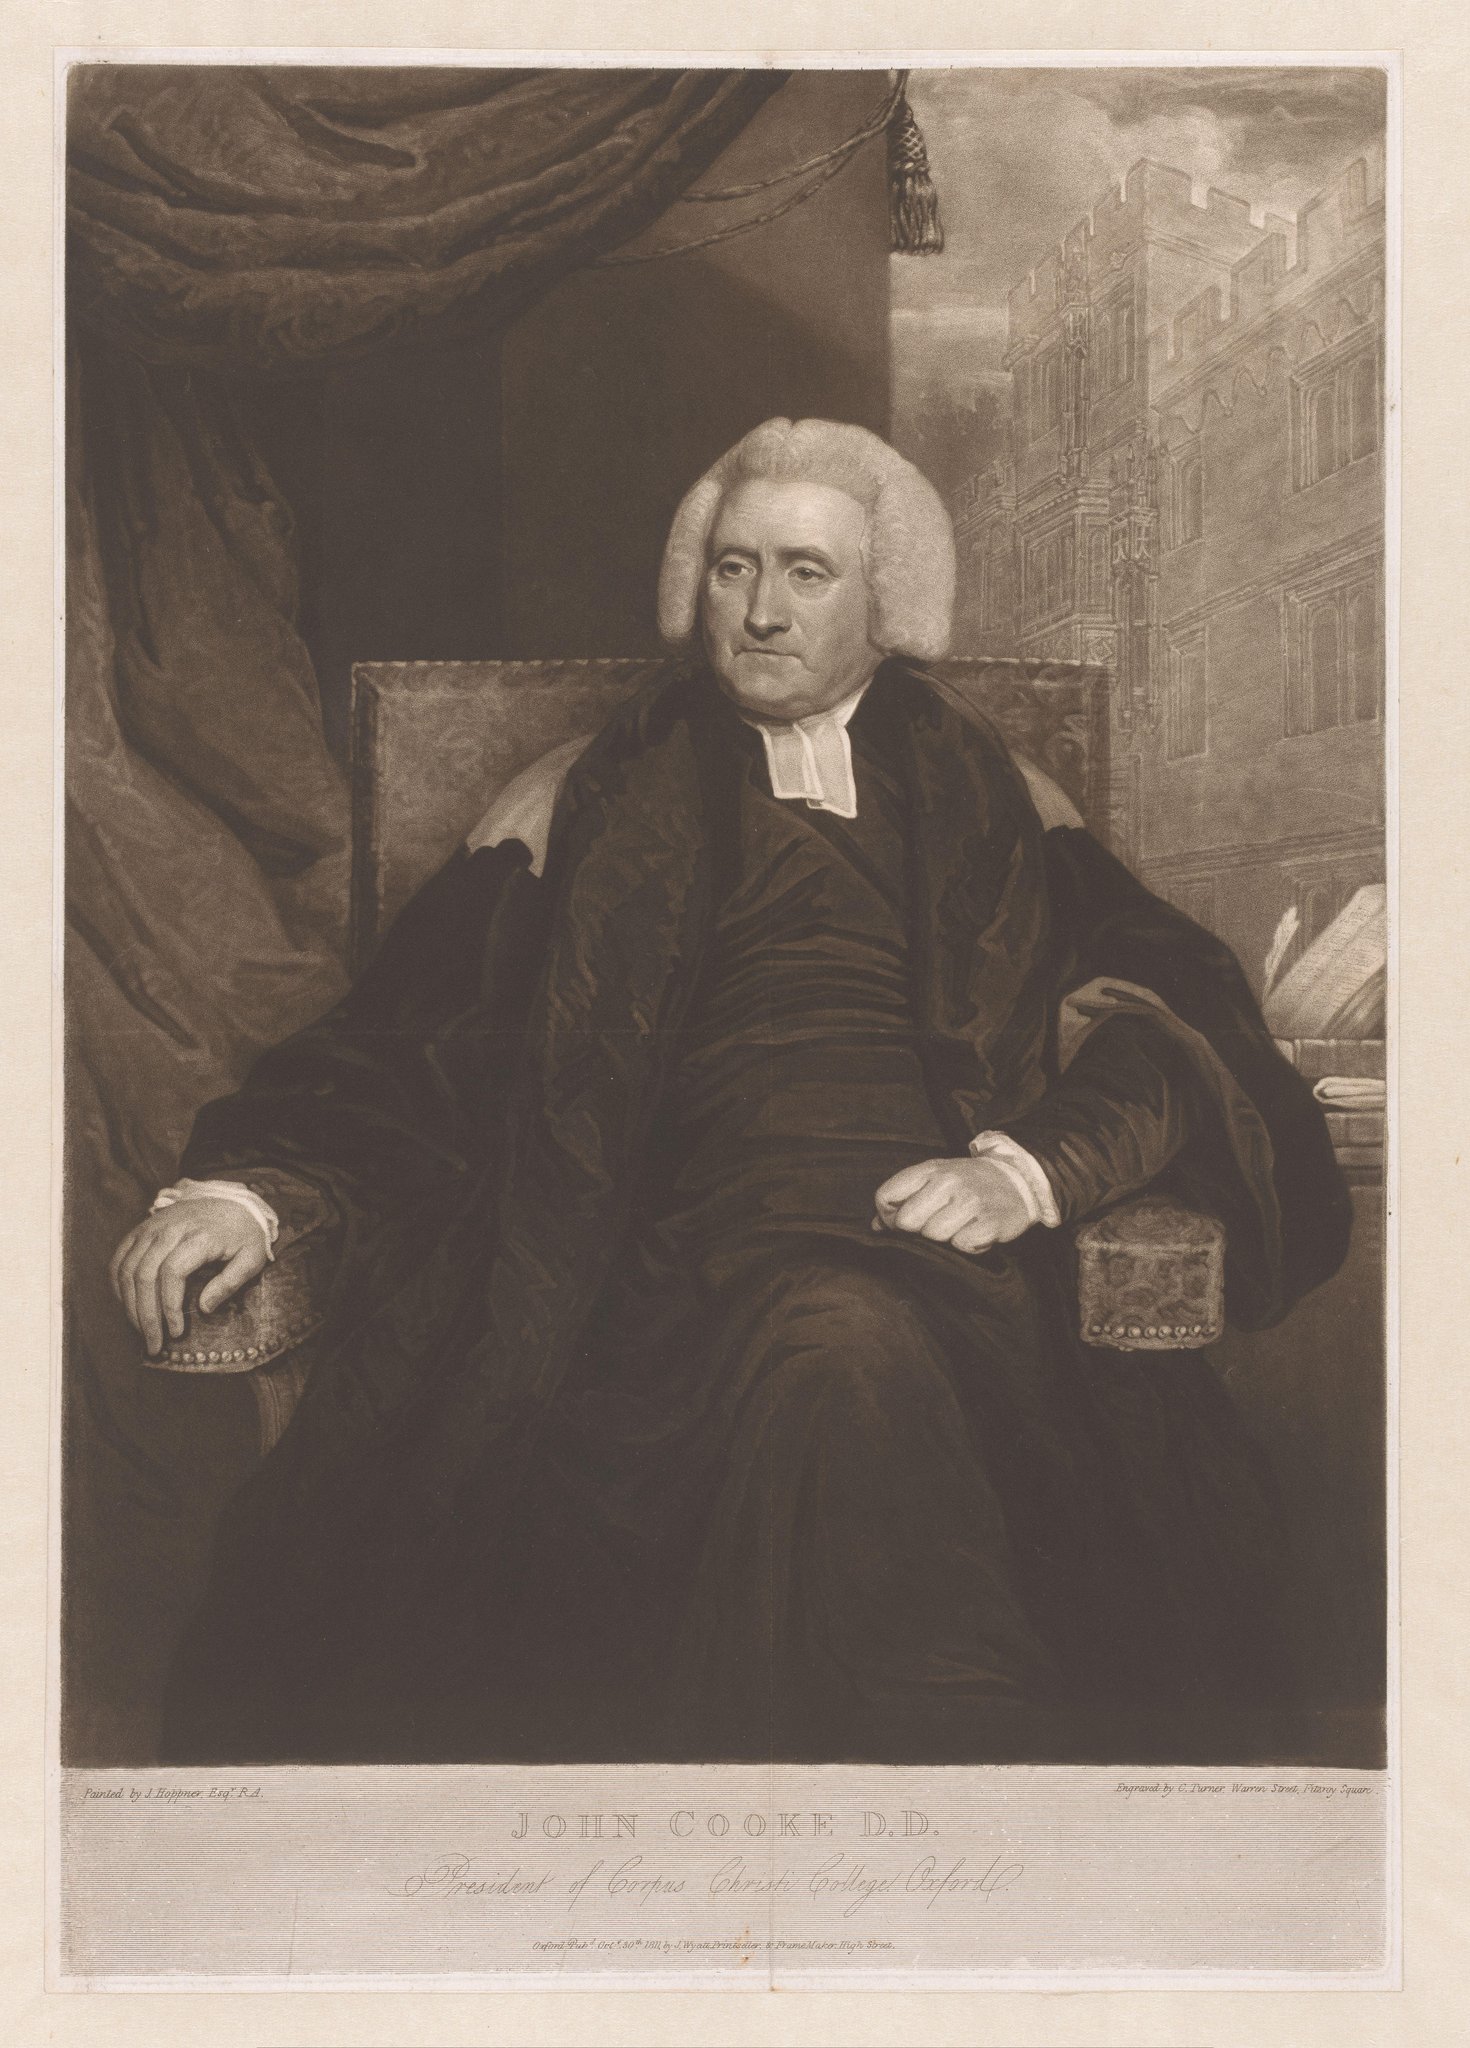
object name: print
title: Portret van John Cooke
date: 1810-1811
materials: paper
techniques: mezzotint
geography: oxford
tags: historical persons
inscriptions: collector's mark: Lugt 2228